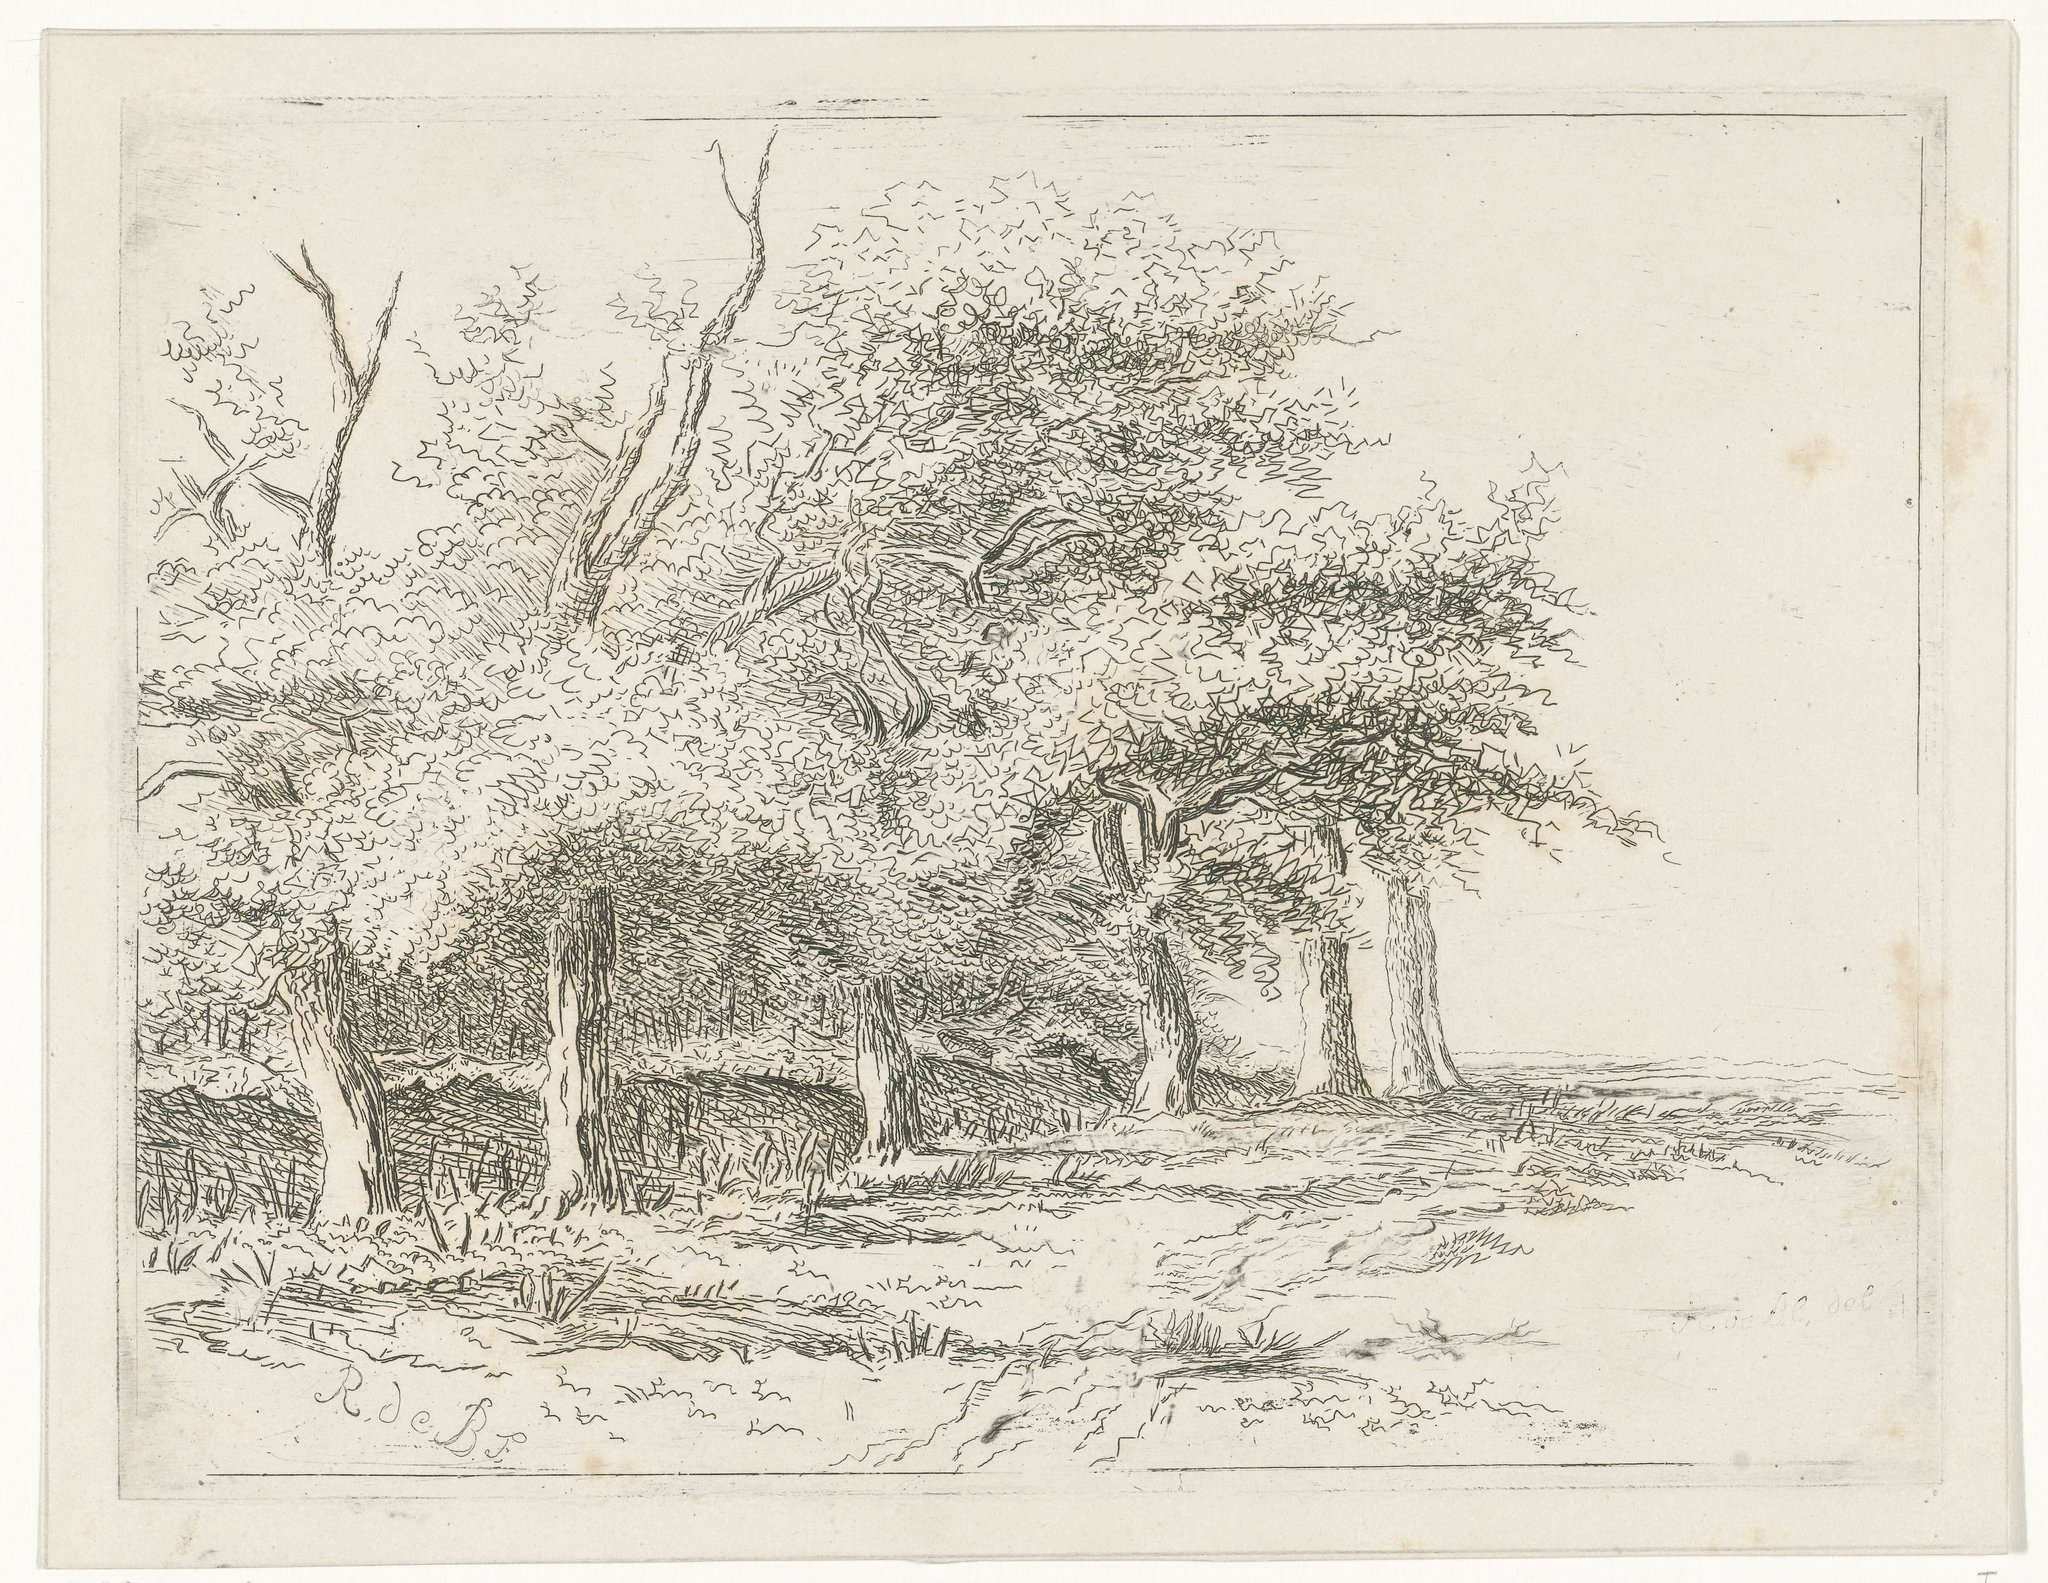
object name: print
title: Rij bomen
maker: reinierus albertus ludovicus baron van isendoorn à blois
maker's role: print maker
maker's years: 1786-1856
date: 1796-1856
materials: paper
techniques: engraving, etching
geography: vaassen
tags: trees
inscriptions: collector's mark: Lugt 2228